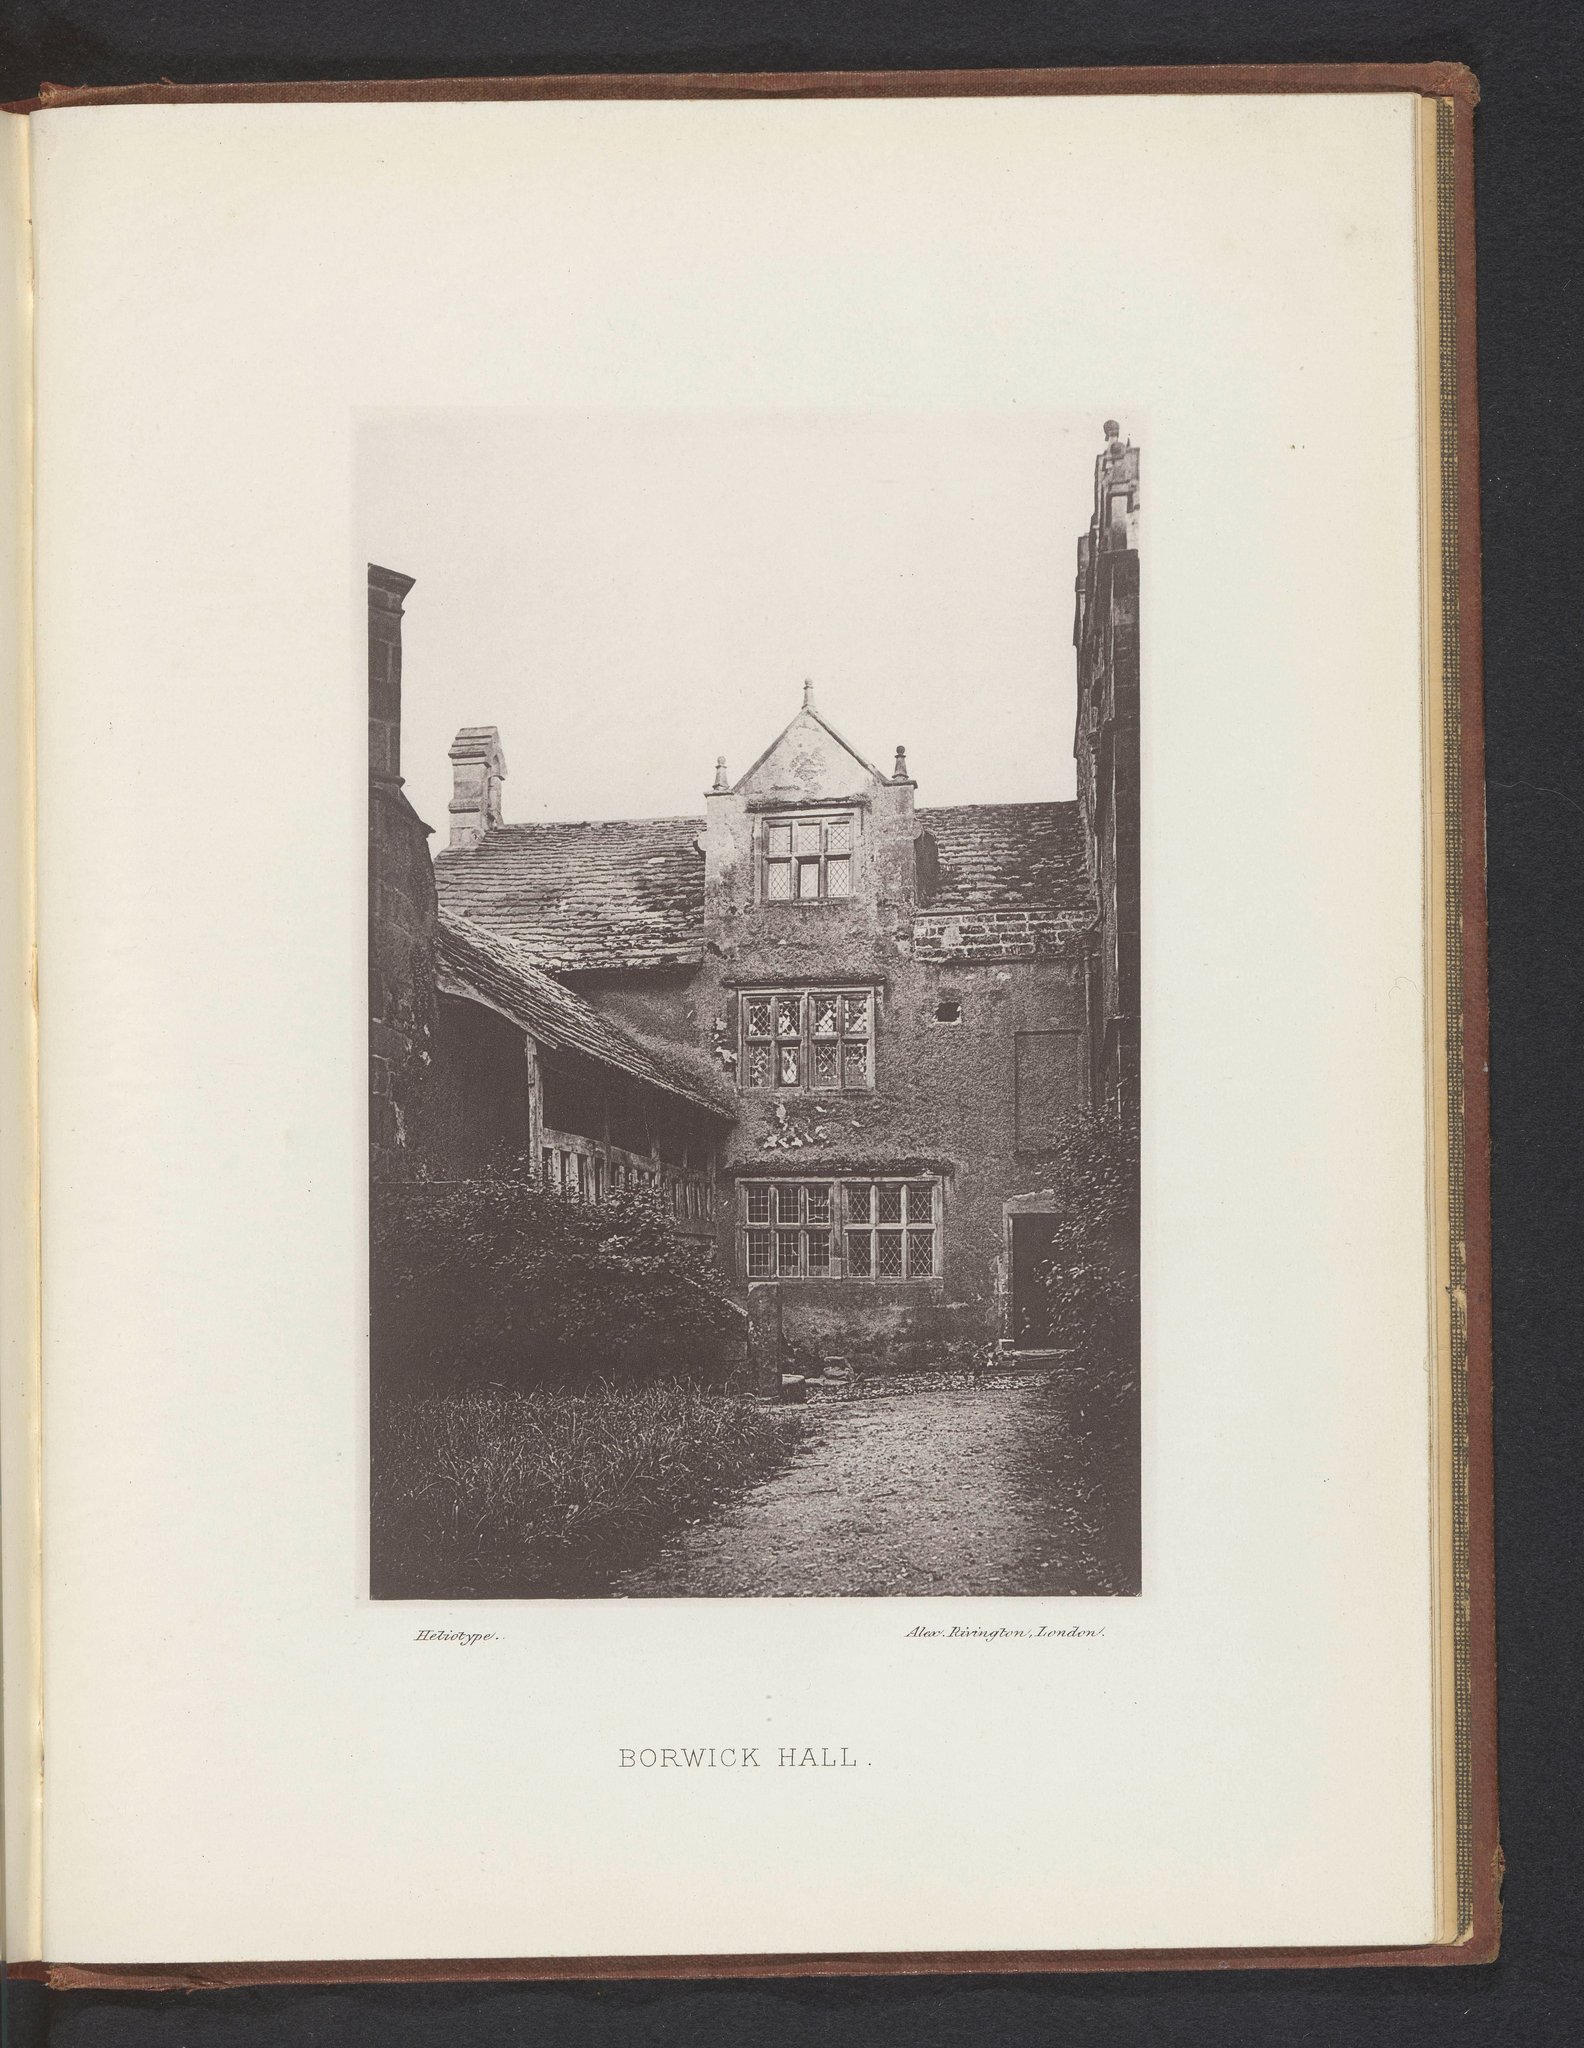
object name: photomechanical print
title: Borwick Hall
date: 1870-1880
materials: paper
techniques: heliotype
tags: rural housing, e.g. country-house, villa, cottage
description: Prent tegenover pagina 20 van het achterste katern.